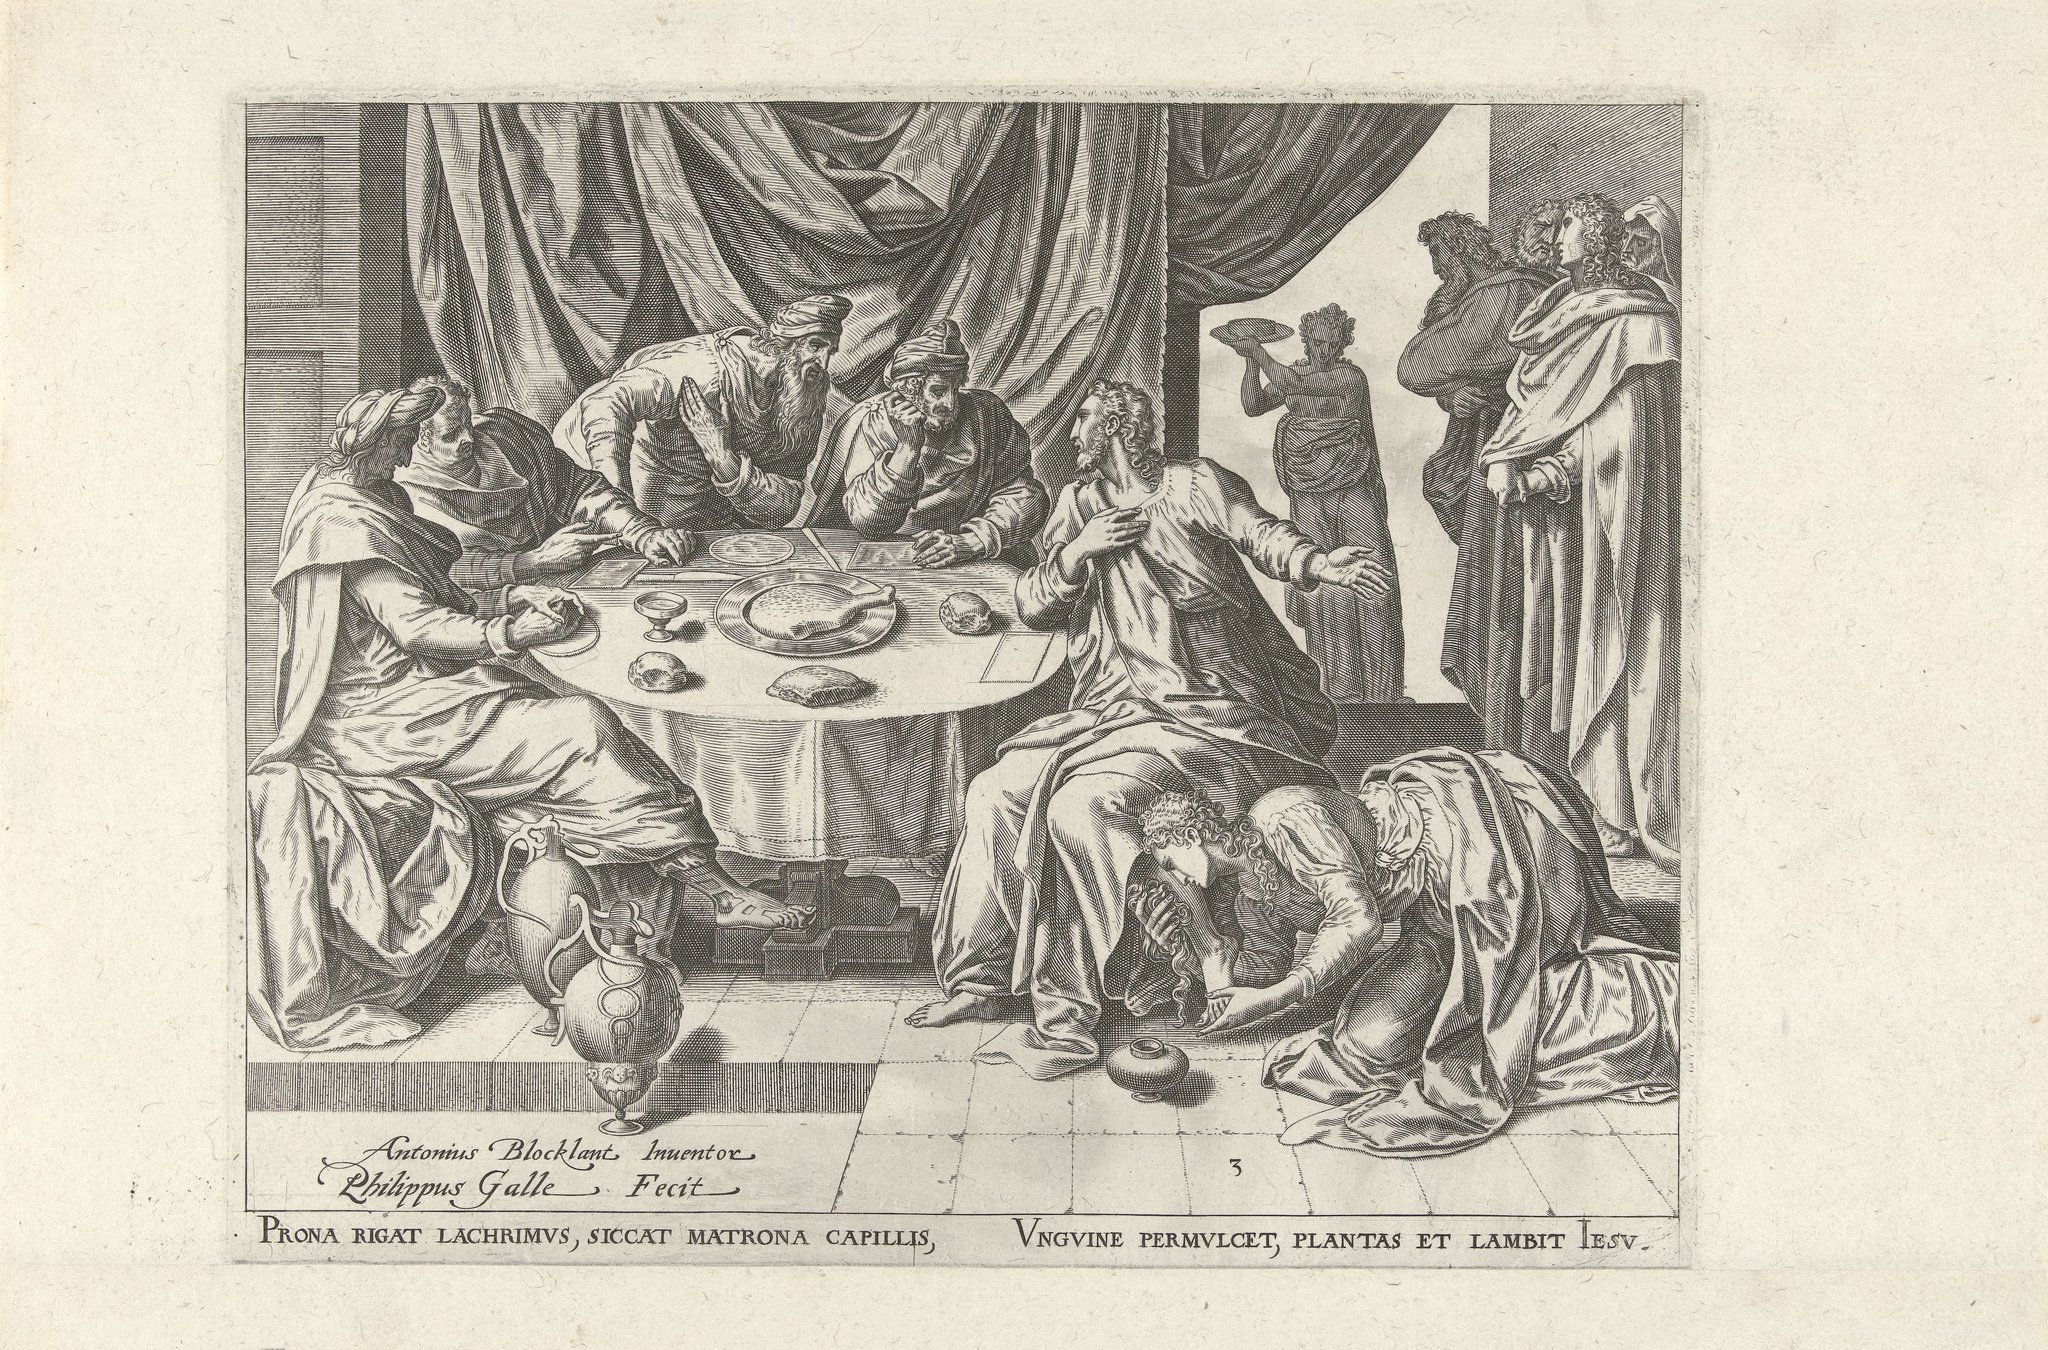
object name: print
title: Christus gezalfd door Maria Magdalena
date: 1577-1579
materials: paper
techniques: engraving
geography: antwerp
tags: christ's feet are anointed by mary (magdalene)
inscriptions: collector's mark: Lugt 2228, collector's mark: Lugt 2760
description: Christus zit aan tafel te eten in het huis van Simon de Farizeeër. Maria Magdalena knielt op de grond naast hem, oliet zijn voeten en droogt ze met haar haren.